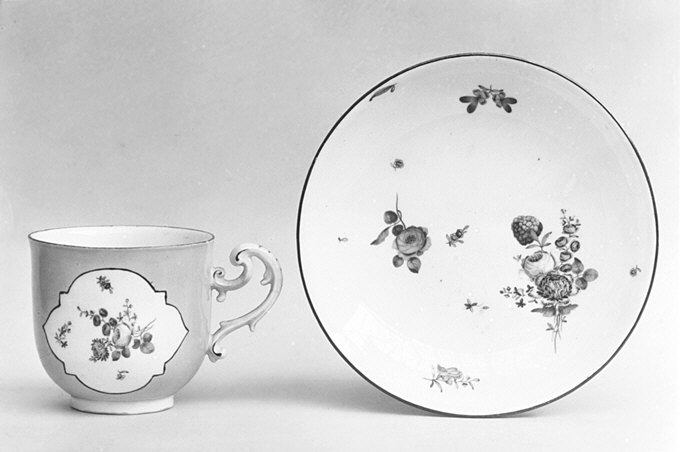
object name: cup and saucer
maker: meissen manufactory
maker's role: manufactory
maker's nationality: german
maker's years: 1710-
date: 1740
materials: hard paste porcelain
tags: flowers